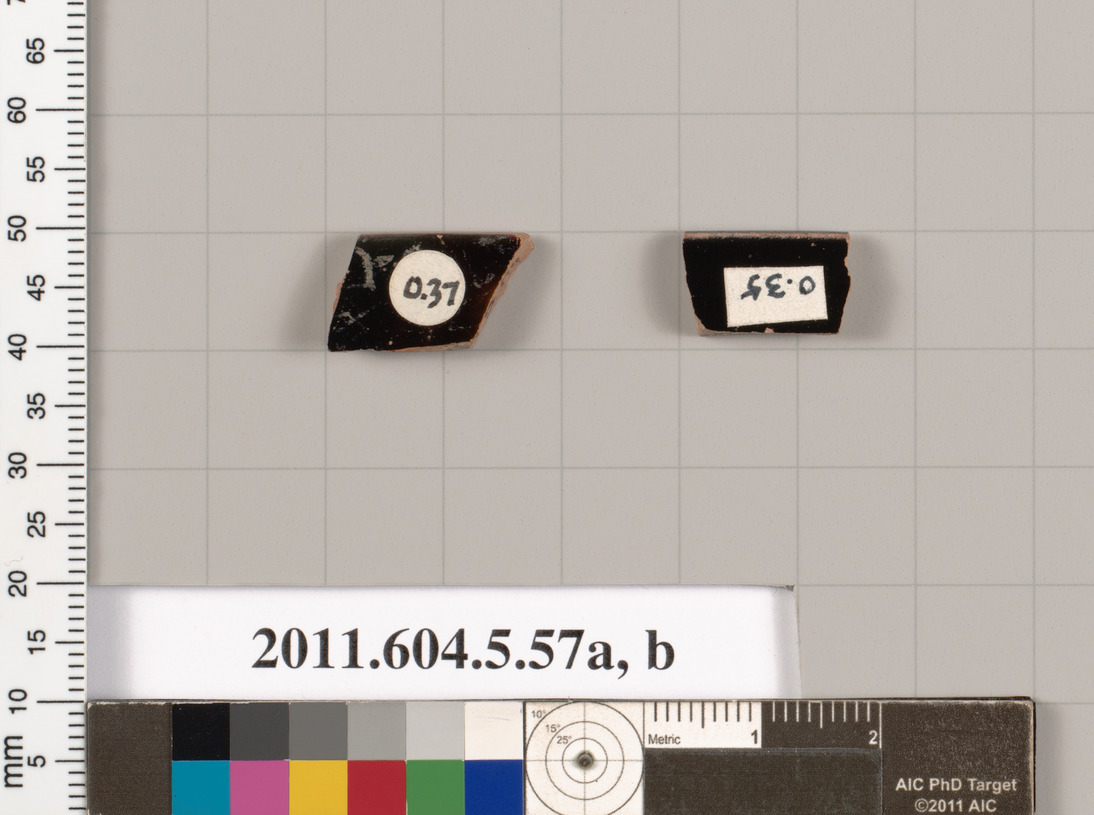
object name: kylix fragment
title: Terracotta rim fragments of kylikes (drinking cups)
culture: greek, attic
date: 500-401 BCE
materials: terracotta